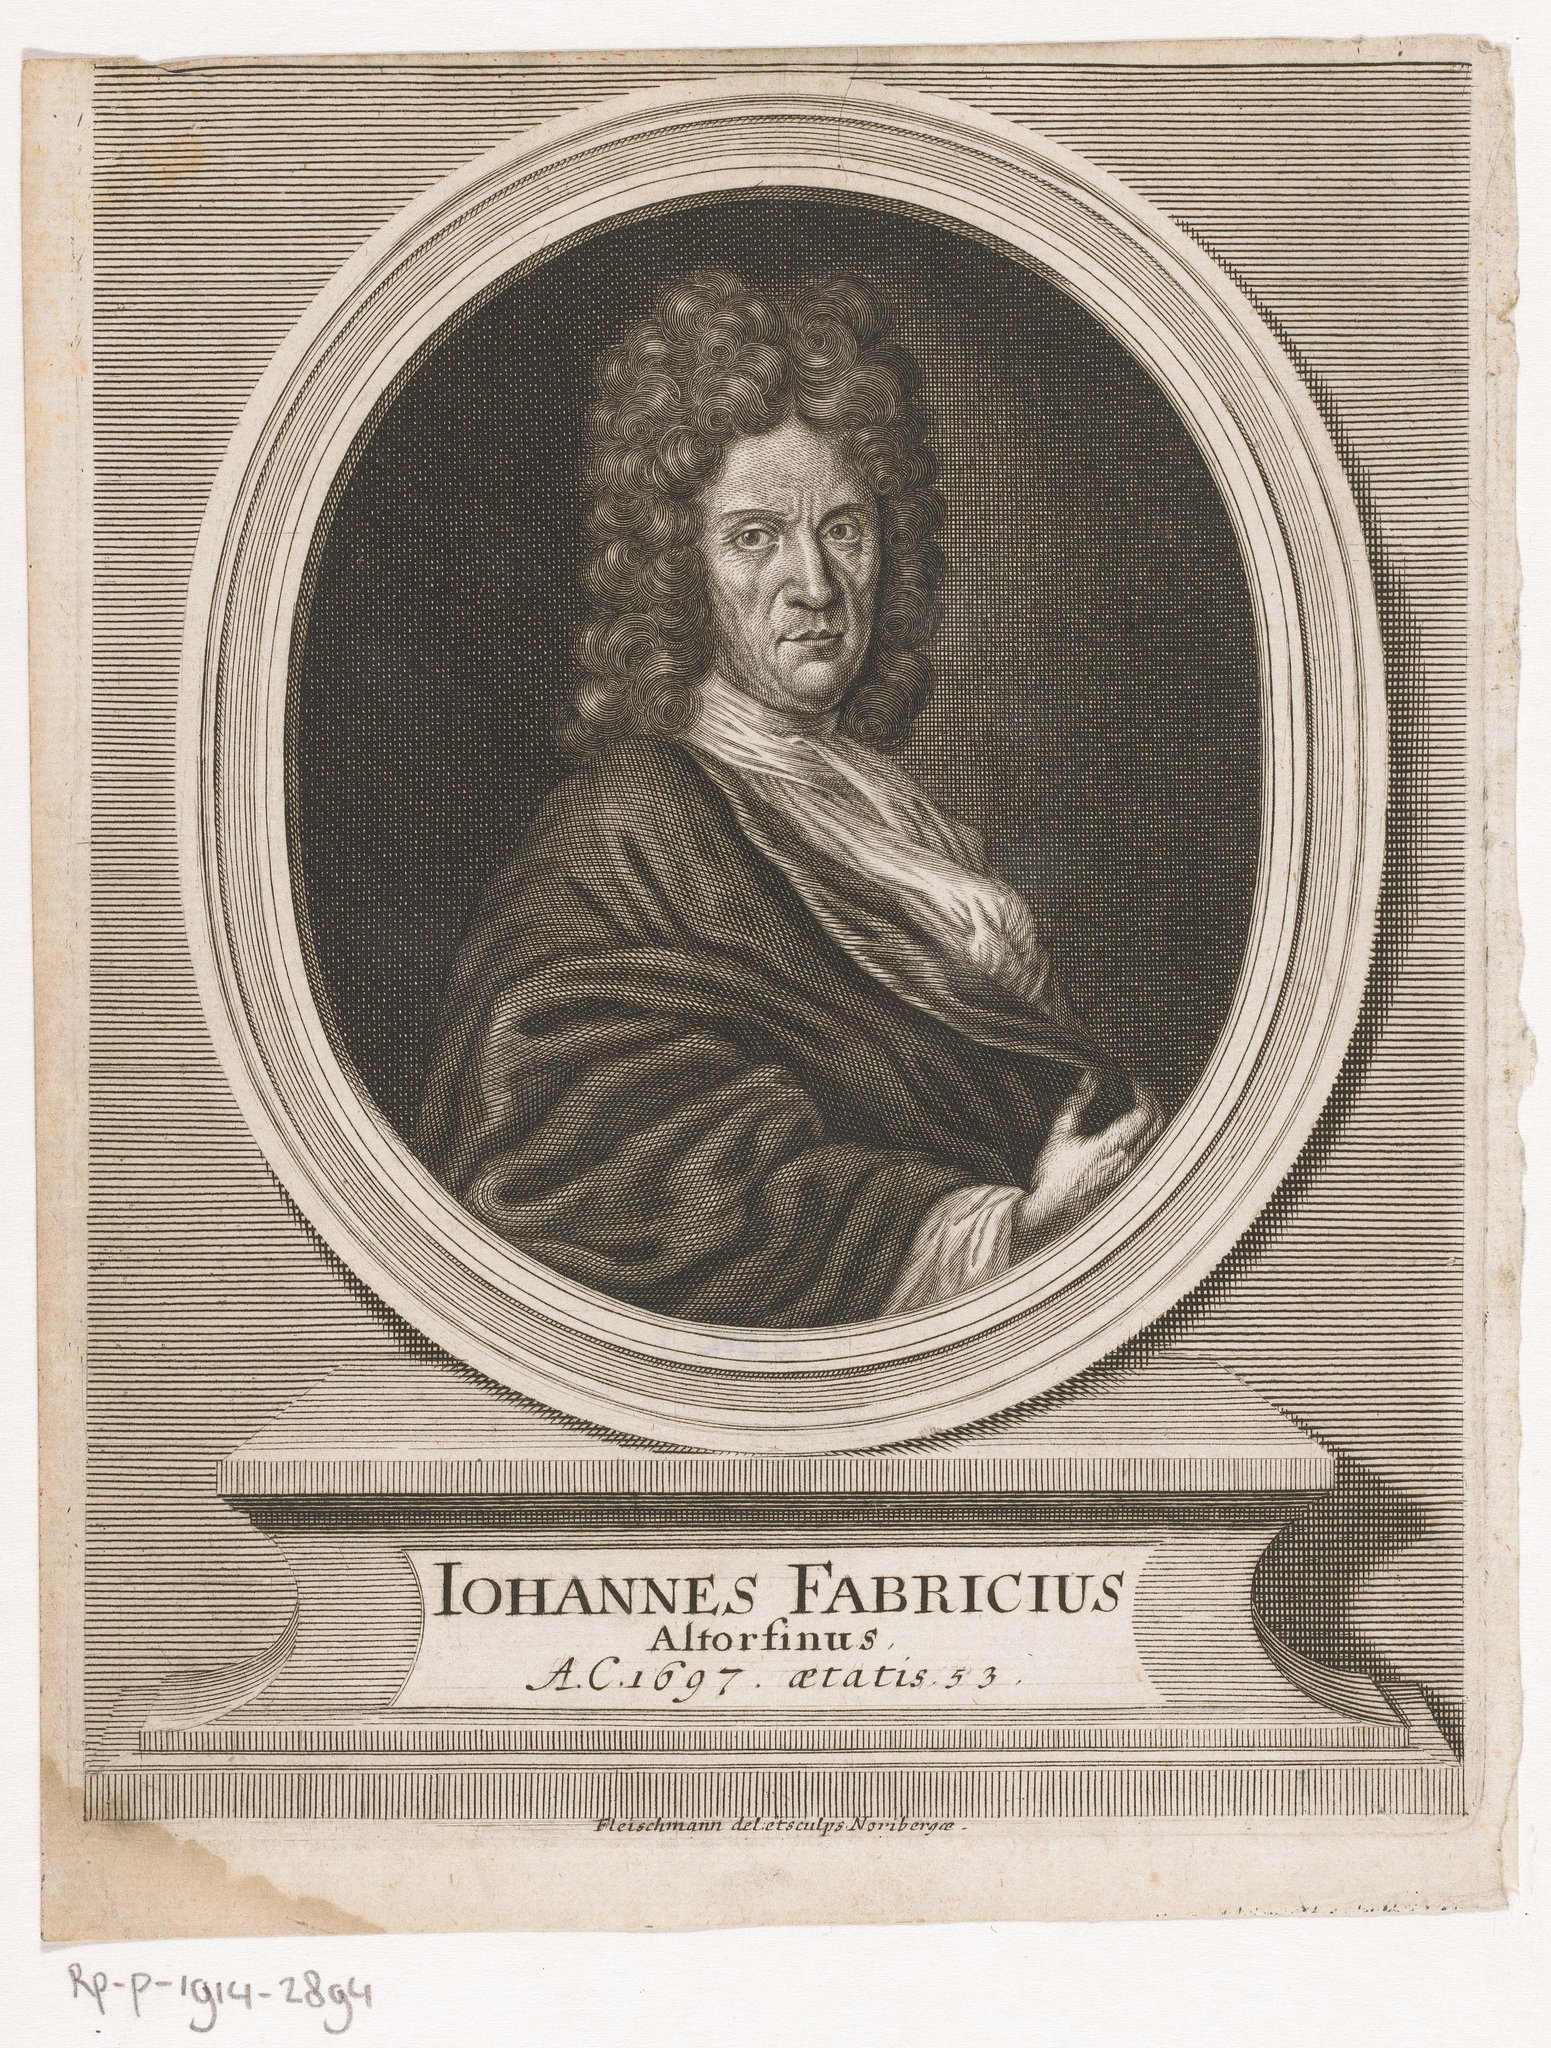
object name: print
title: Portret van Johann Fabricius op 53-jarige leeftijd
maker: august christian fleischmann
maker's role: print maker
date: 1697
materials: paper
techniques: engraving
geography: nuremberg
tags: historical persons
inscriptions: collector's mark: Lugt 2228